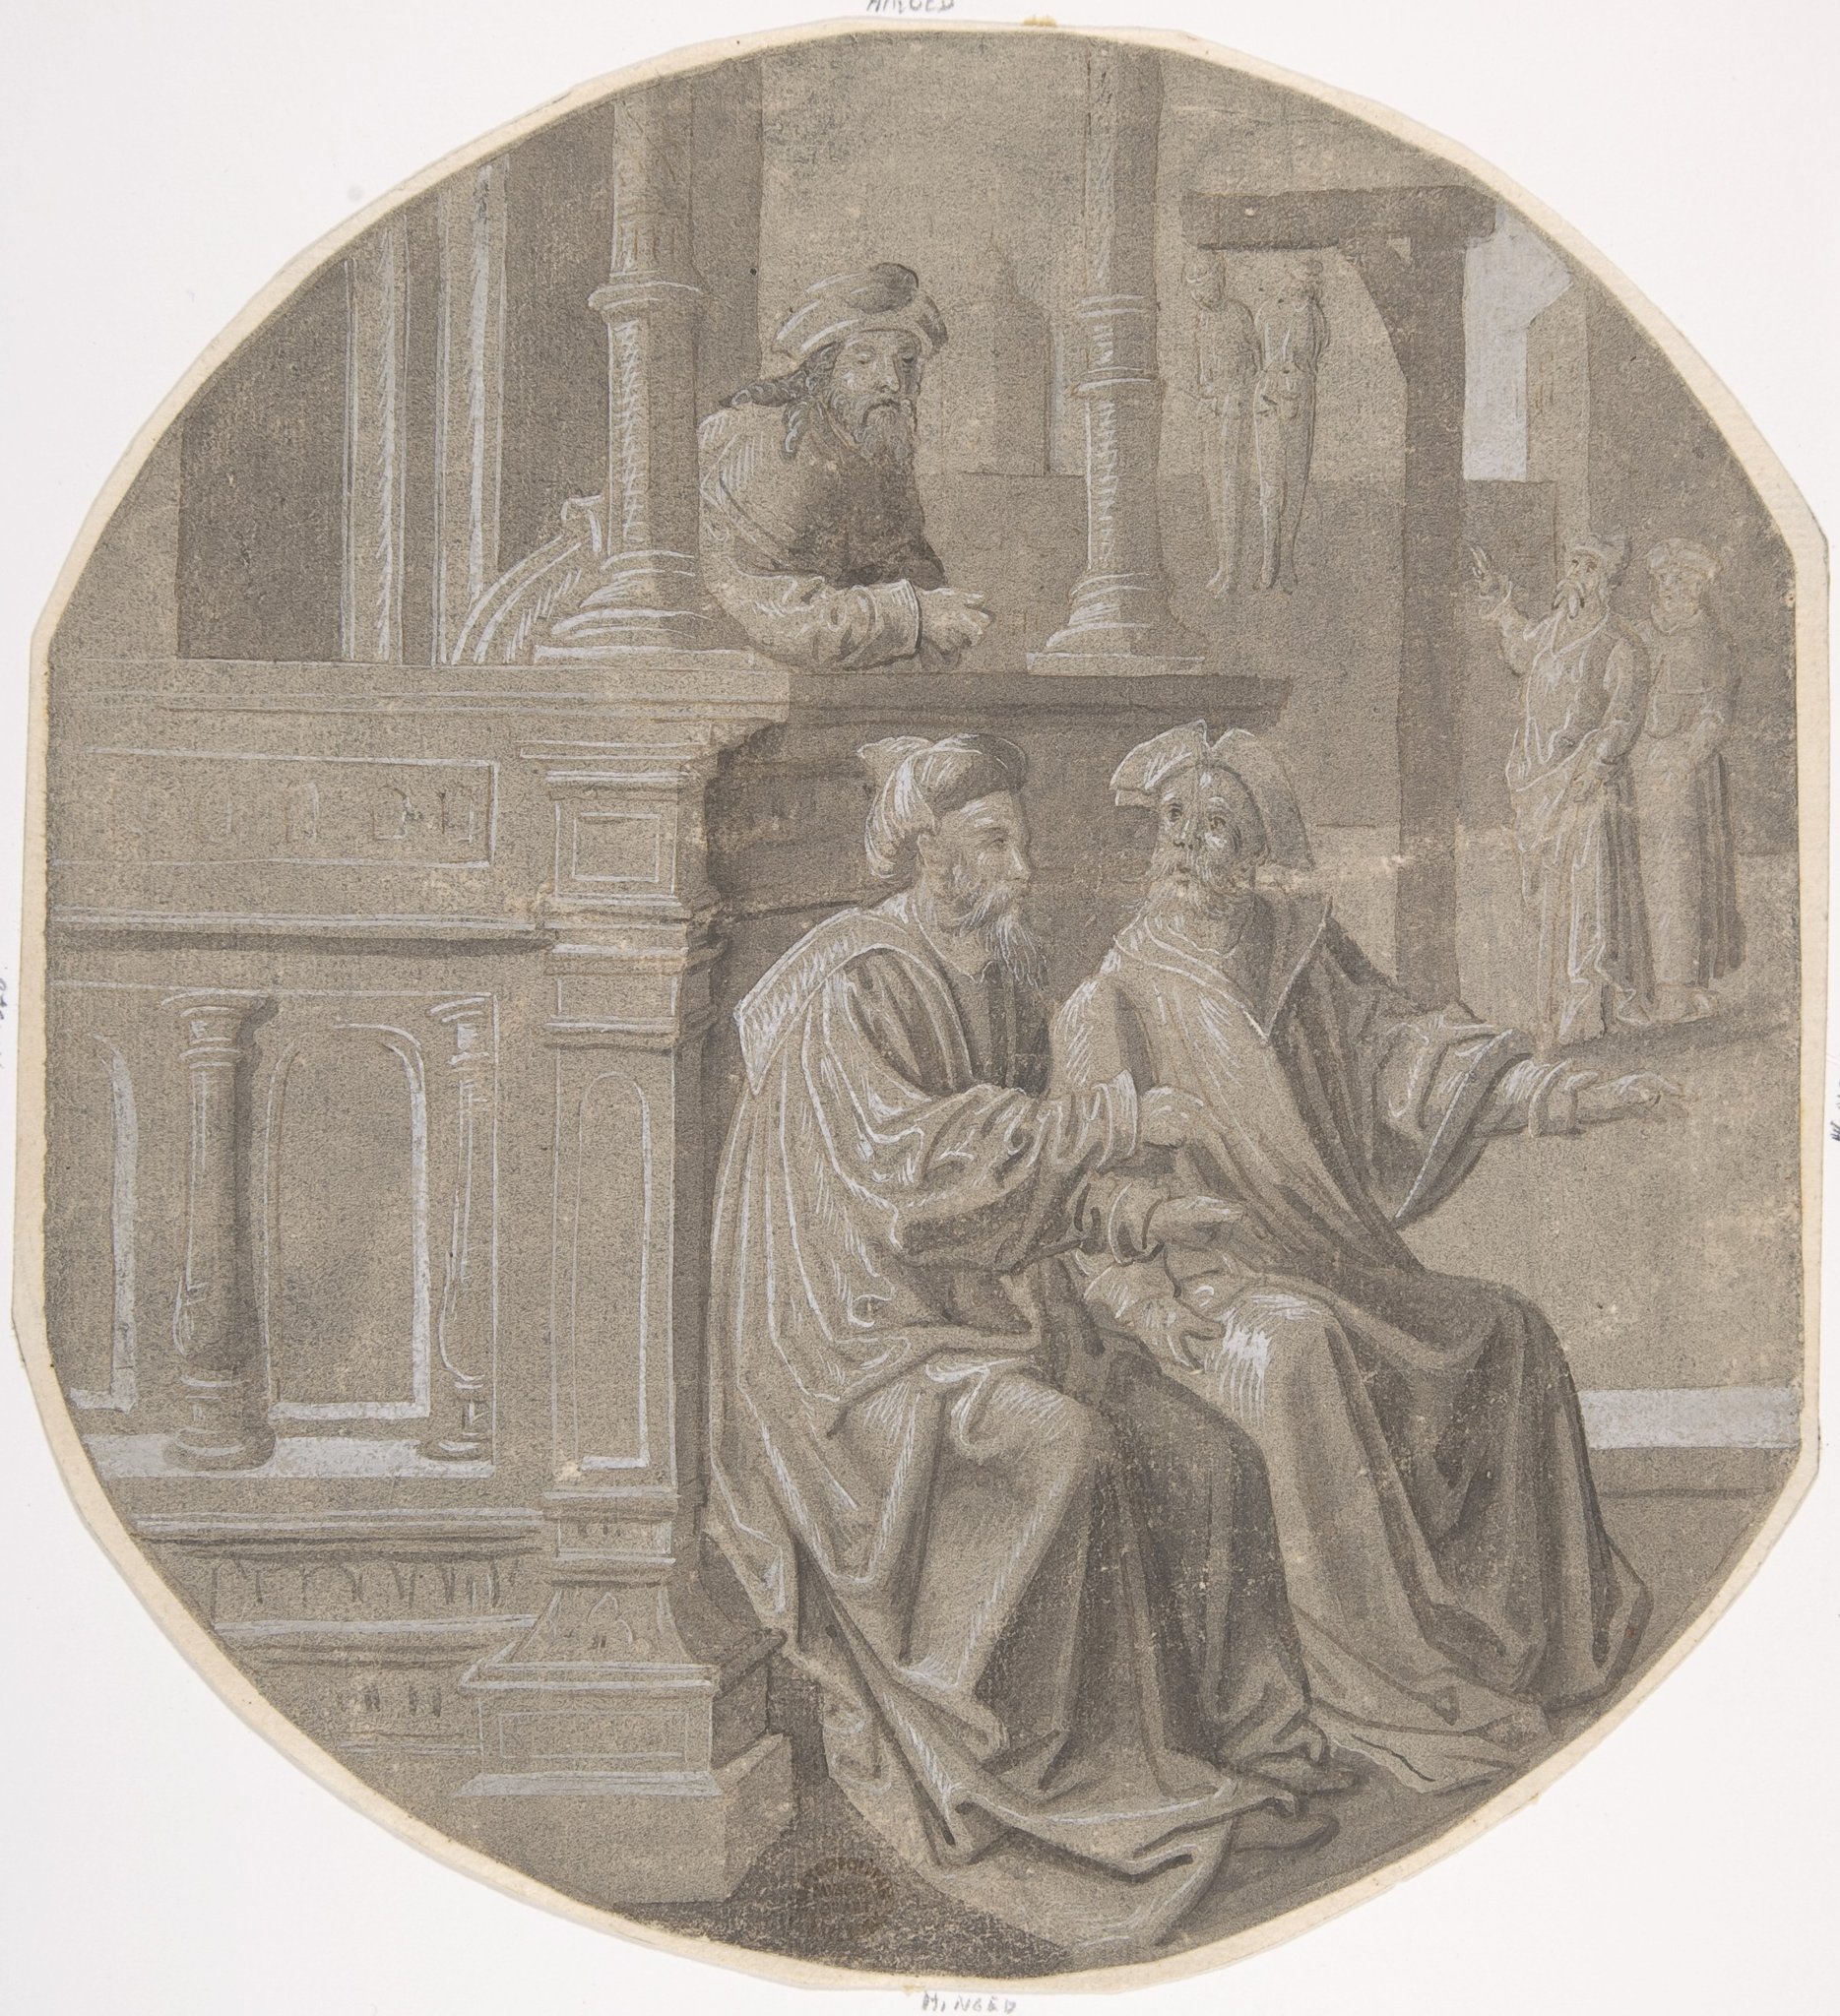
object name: drawing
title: Mordecai overhears the two Conspirators plotting against the King.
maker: pseudo-aert ortkens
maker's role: artist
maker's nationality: netherlandish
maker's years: 1510-1540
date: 1501-1566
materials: ink, paper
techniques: brush, highlighting, pen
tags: men